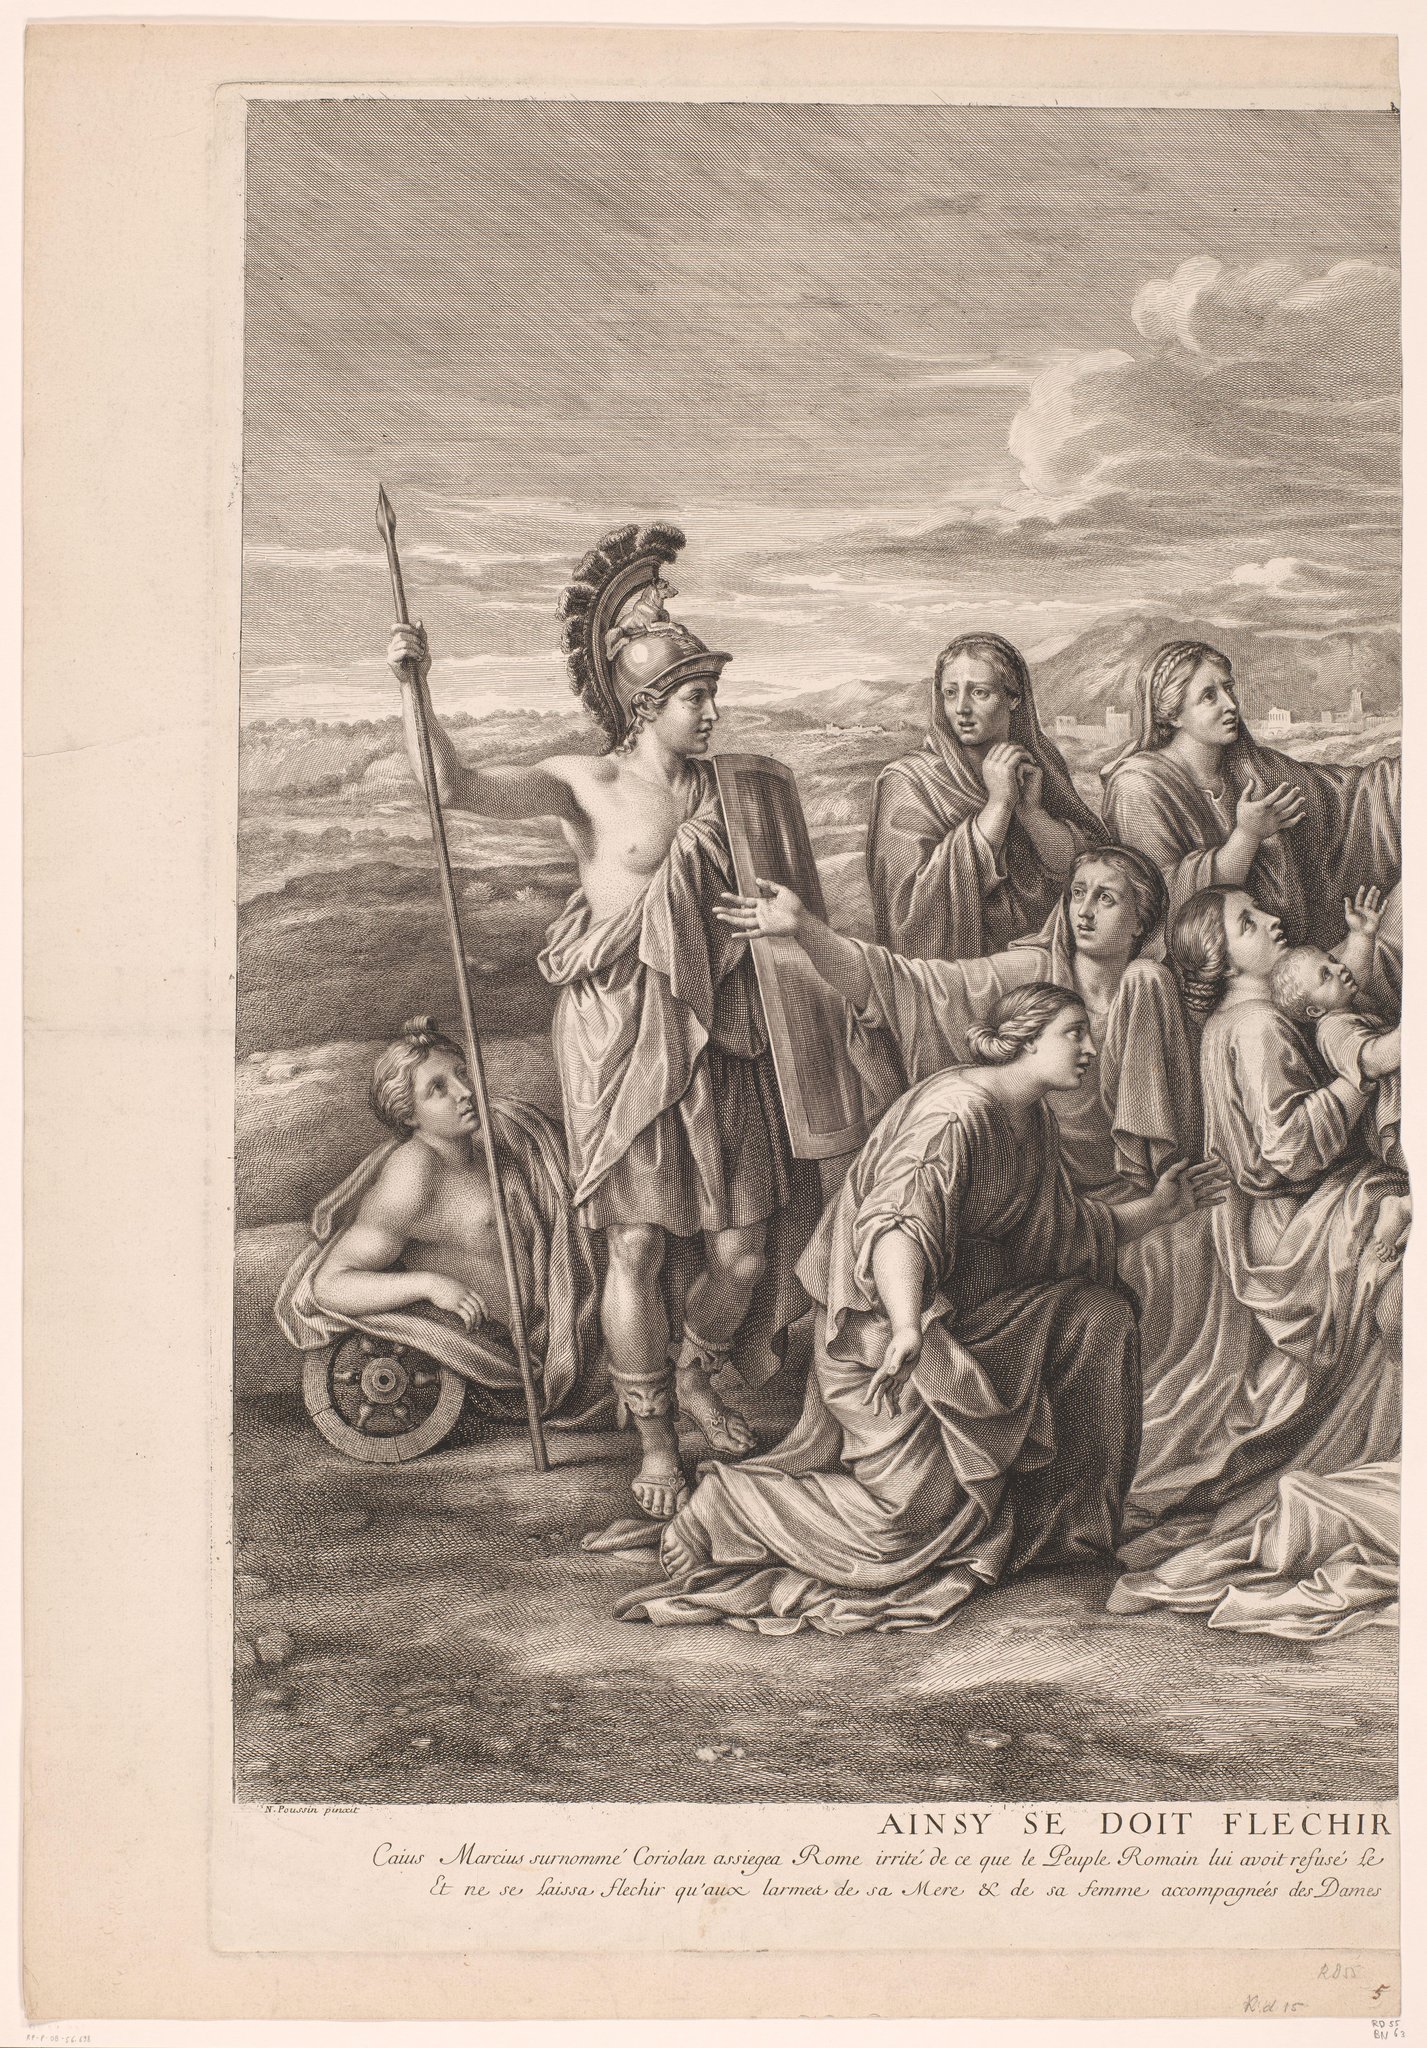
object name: print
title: Volumnia met haar zonen voor Coriolanus (linkerdeel)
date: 1650-1703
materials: paper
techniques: engraving, etching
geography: paris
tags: coriolanus (c. or cn. marcius) is met by his wife volumnia (alternatively called vergilia) with their two small sons, and his mother veturia (alternatively called volumnia); they entreat him not to fight any more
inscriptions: collector's mark: Lugt 240, number: ‘5’